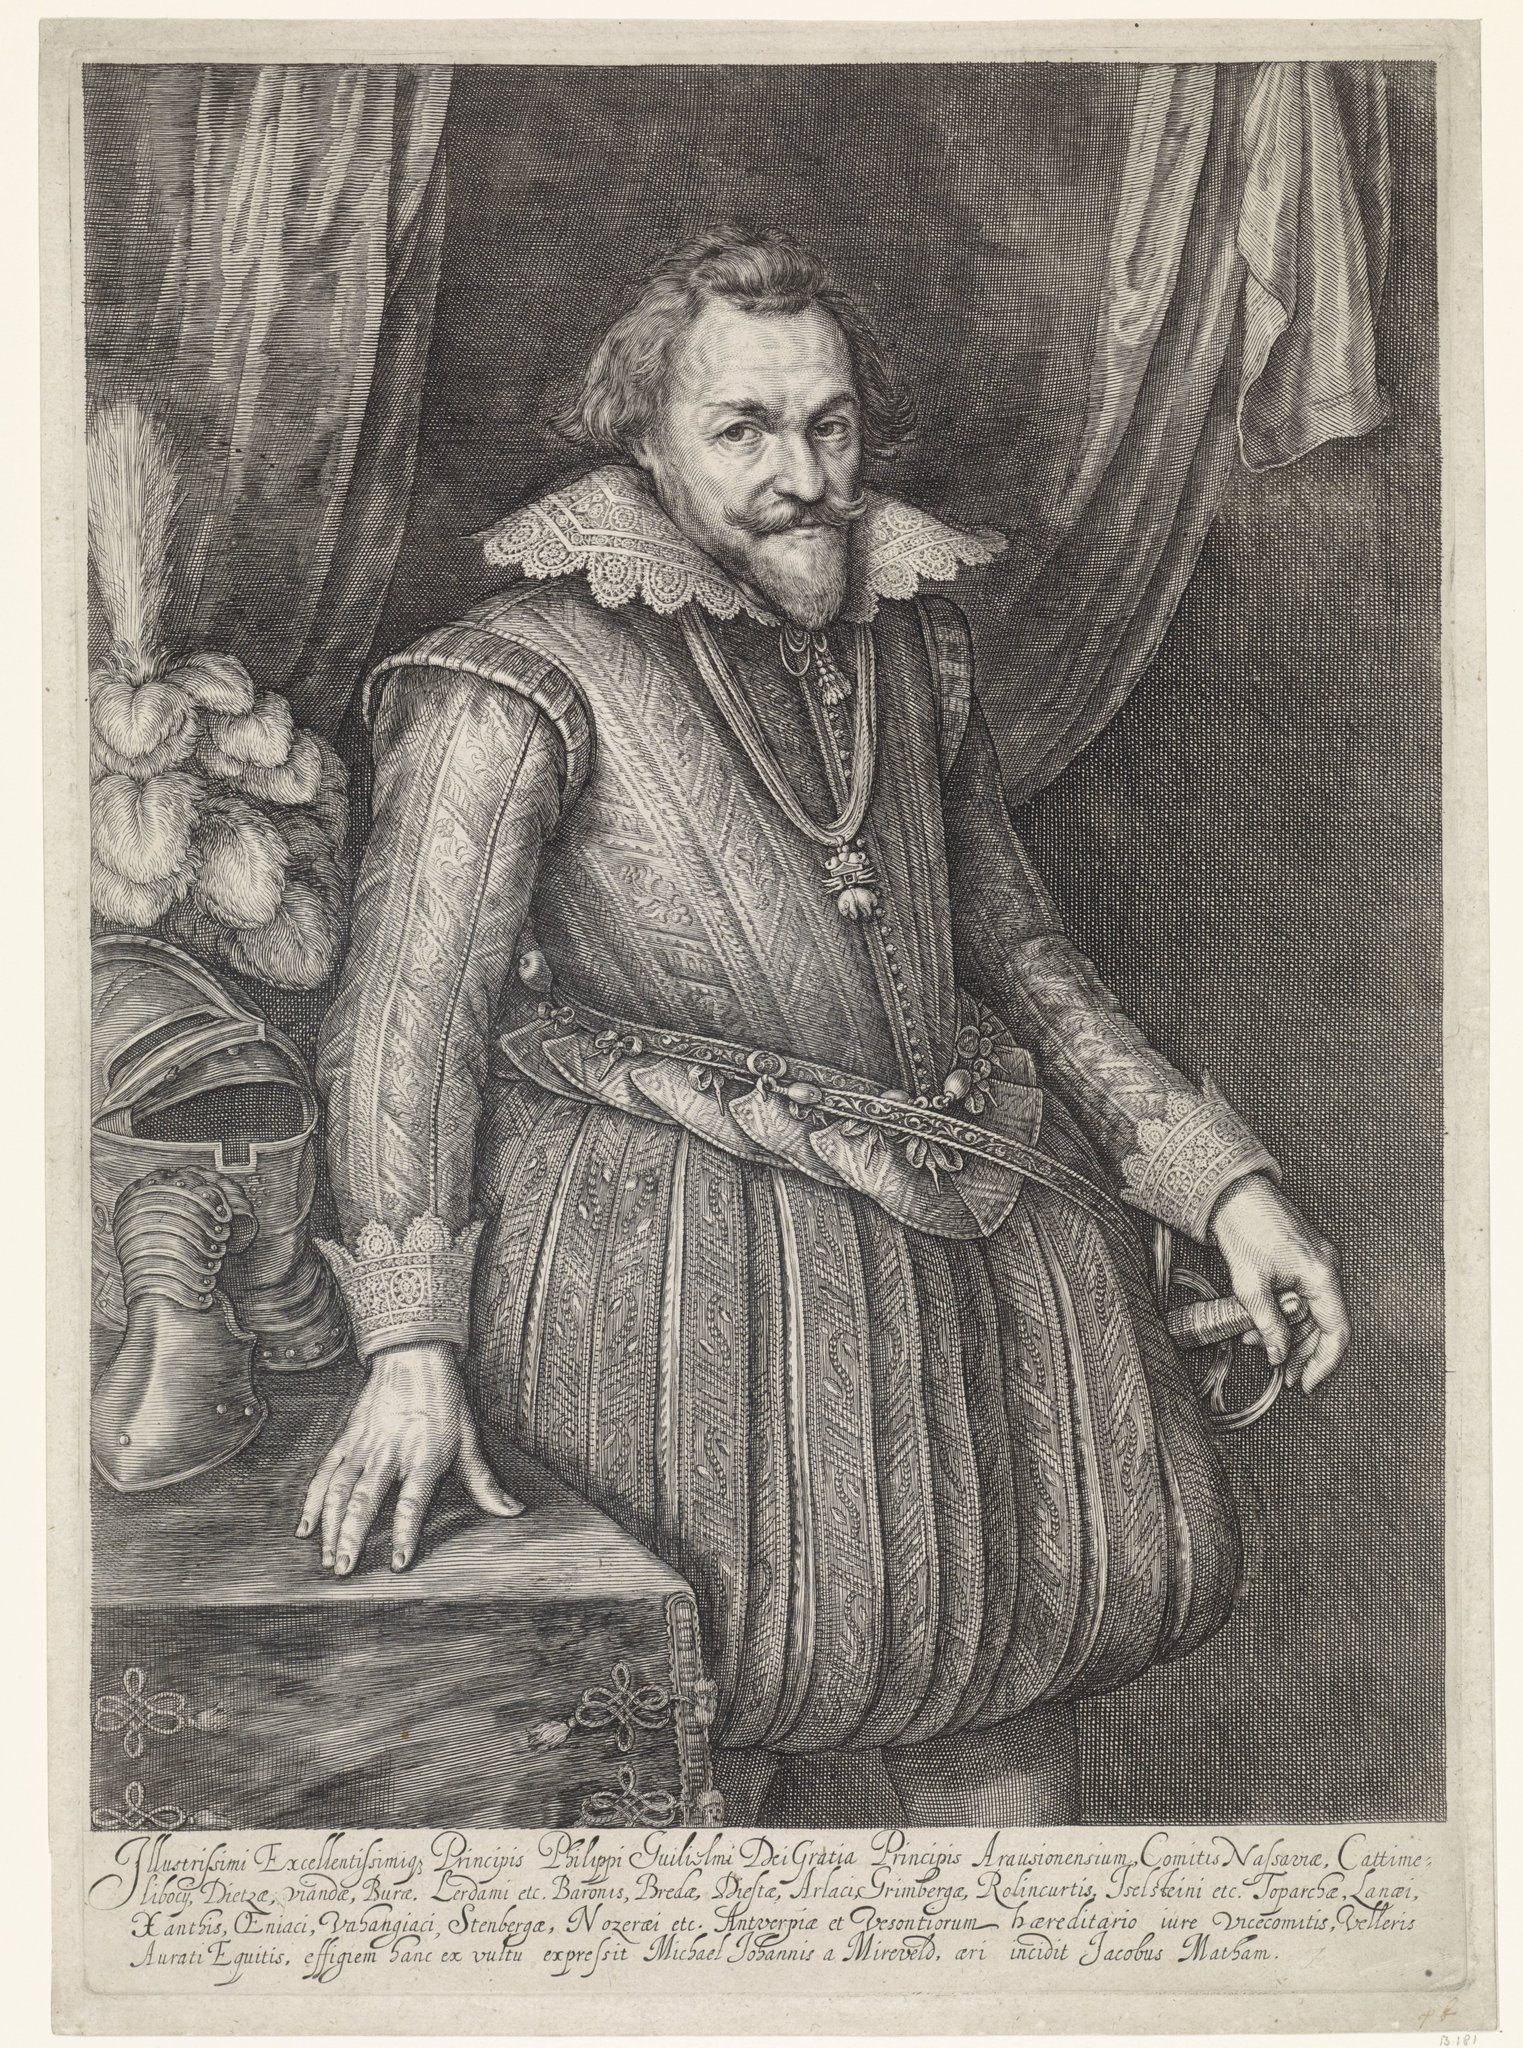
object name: print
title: Portret Philip Willem, prins van Oranje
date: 1610-1618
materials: paper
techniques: engraving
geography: haarlem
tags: buren, bruges, filips willem (prins van oranje), helmet, arm protector, armour, historical persons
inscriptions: number: ‘N. 19505’, collector's mark: Lugt 963, collector's mark: Lugt 2228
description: Kniestuk van Philip Willem, prins van Oranje, gekleed in een harnas, staand naast tafel waarop een gepluimde helm en handschoen. Achter hem een draperie.